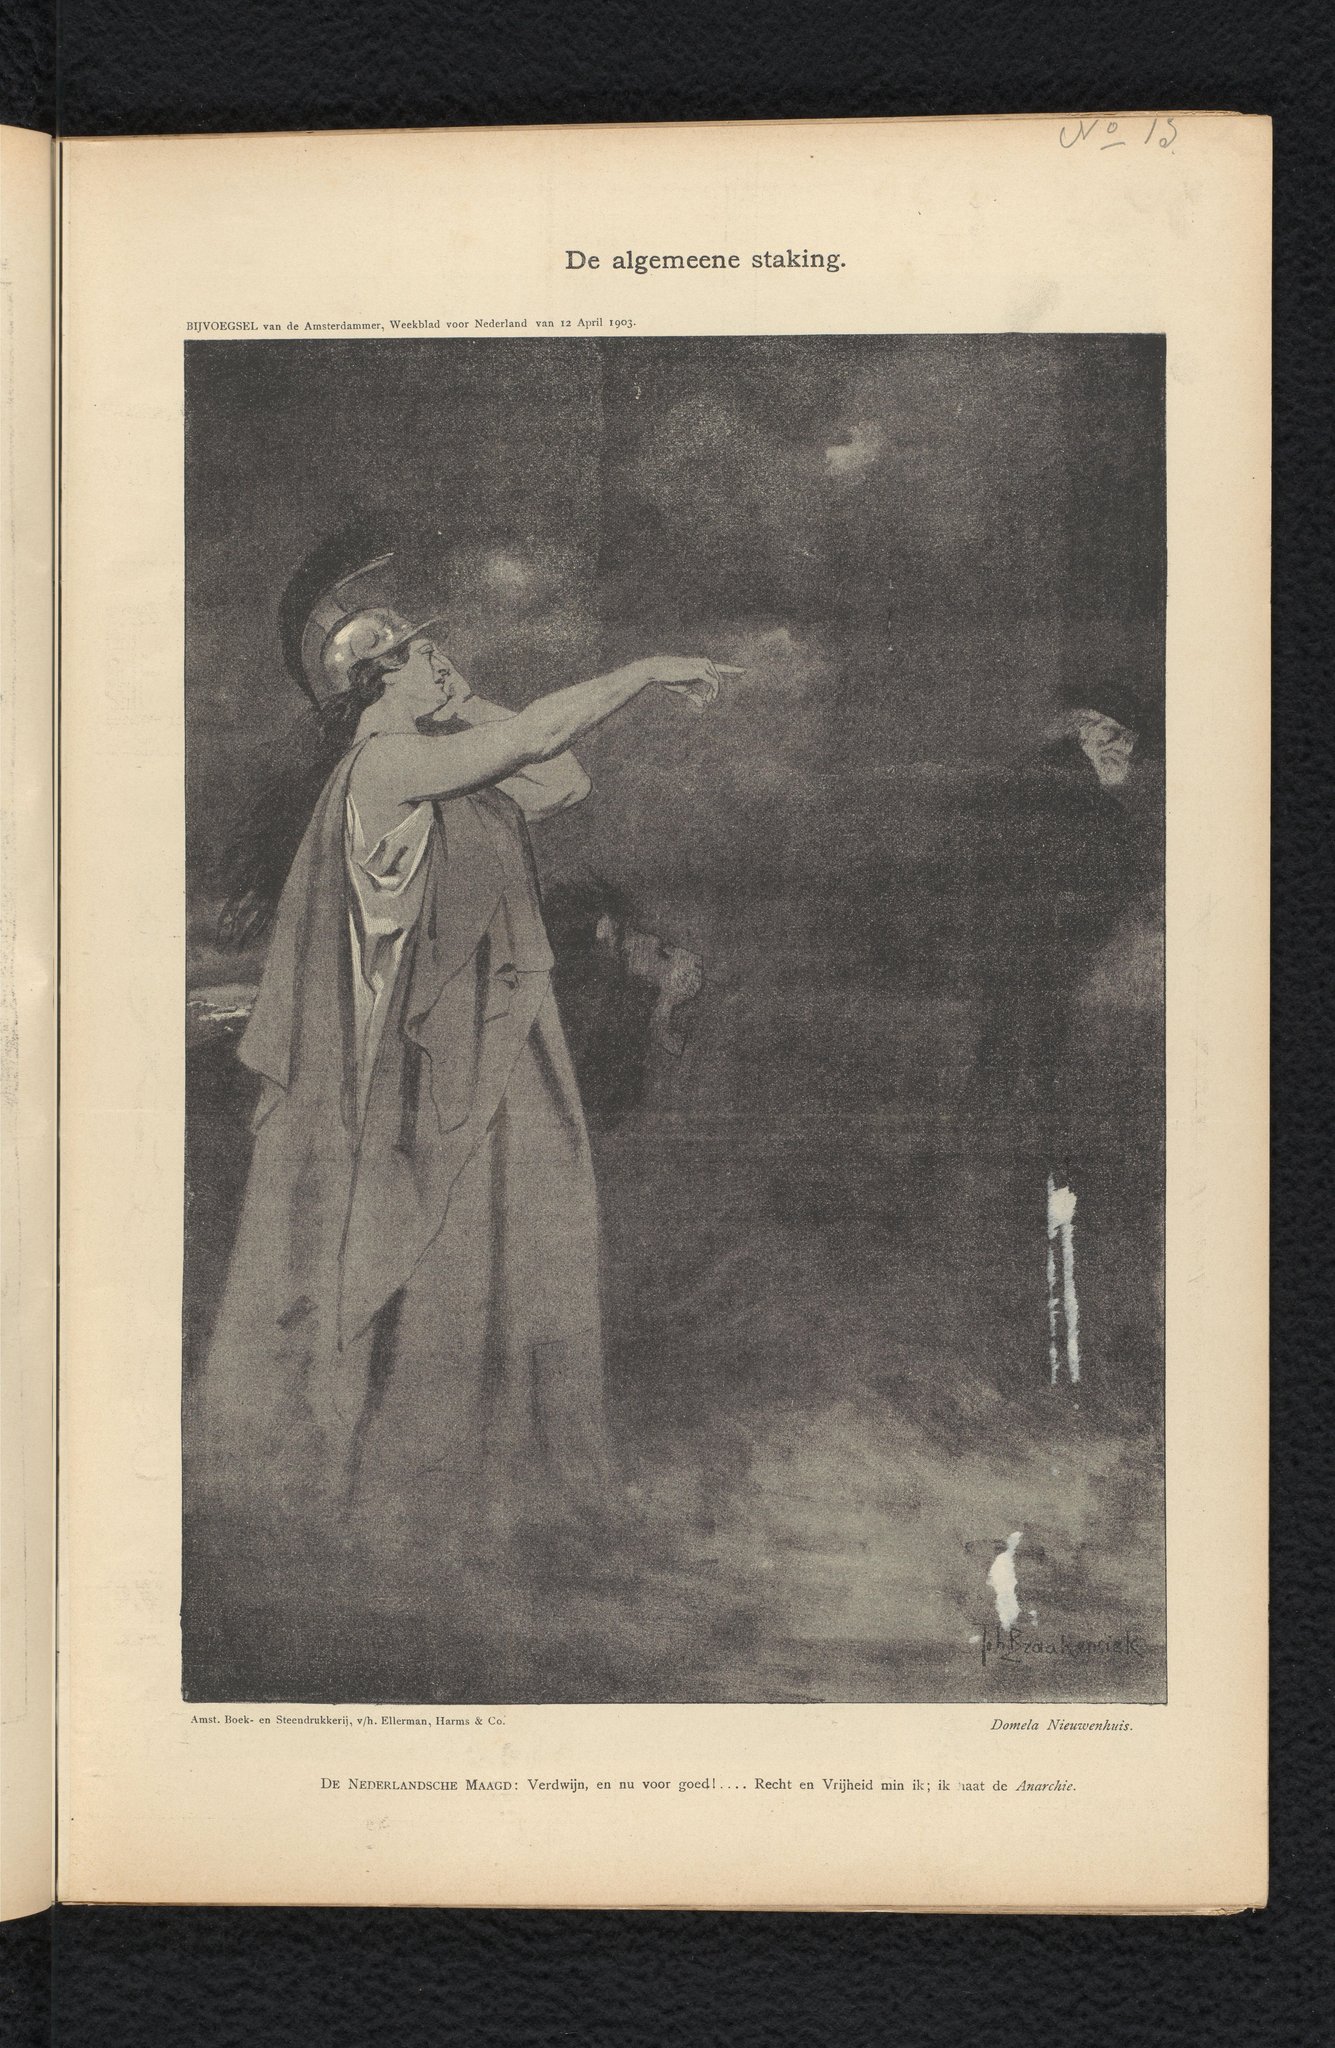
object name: photomechanical print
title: De algemeene staking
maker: johan braakensiek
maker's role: draughtsman, print maker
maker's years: 1858-1940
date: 1903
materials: paper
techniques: autotype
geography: amsterdam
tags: ferdinand domela nieuwenhuis, personifications of countries, nations, states, districts, etc., strike (political demonstration), political caricatures and satires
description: De Nederlandse Maagd is treurig en boos en stuurt de schim van de Anarchie (Domela Nieuwenhuis) weg. Naar aanleiding van het uitbreken van een algemene staking van april 1903.